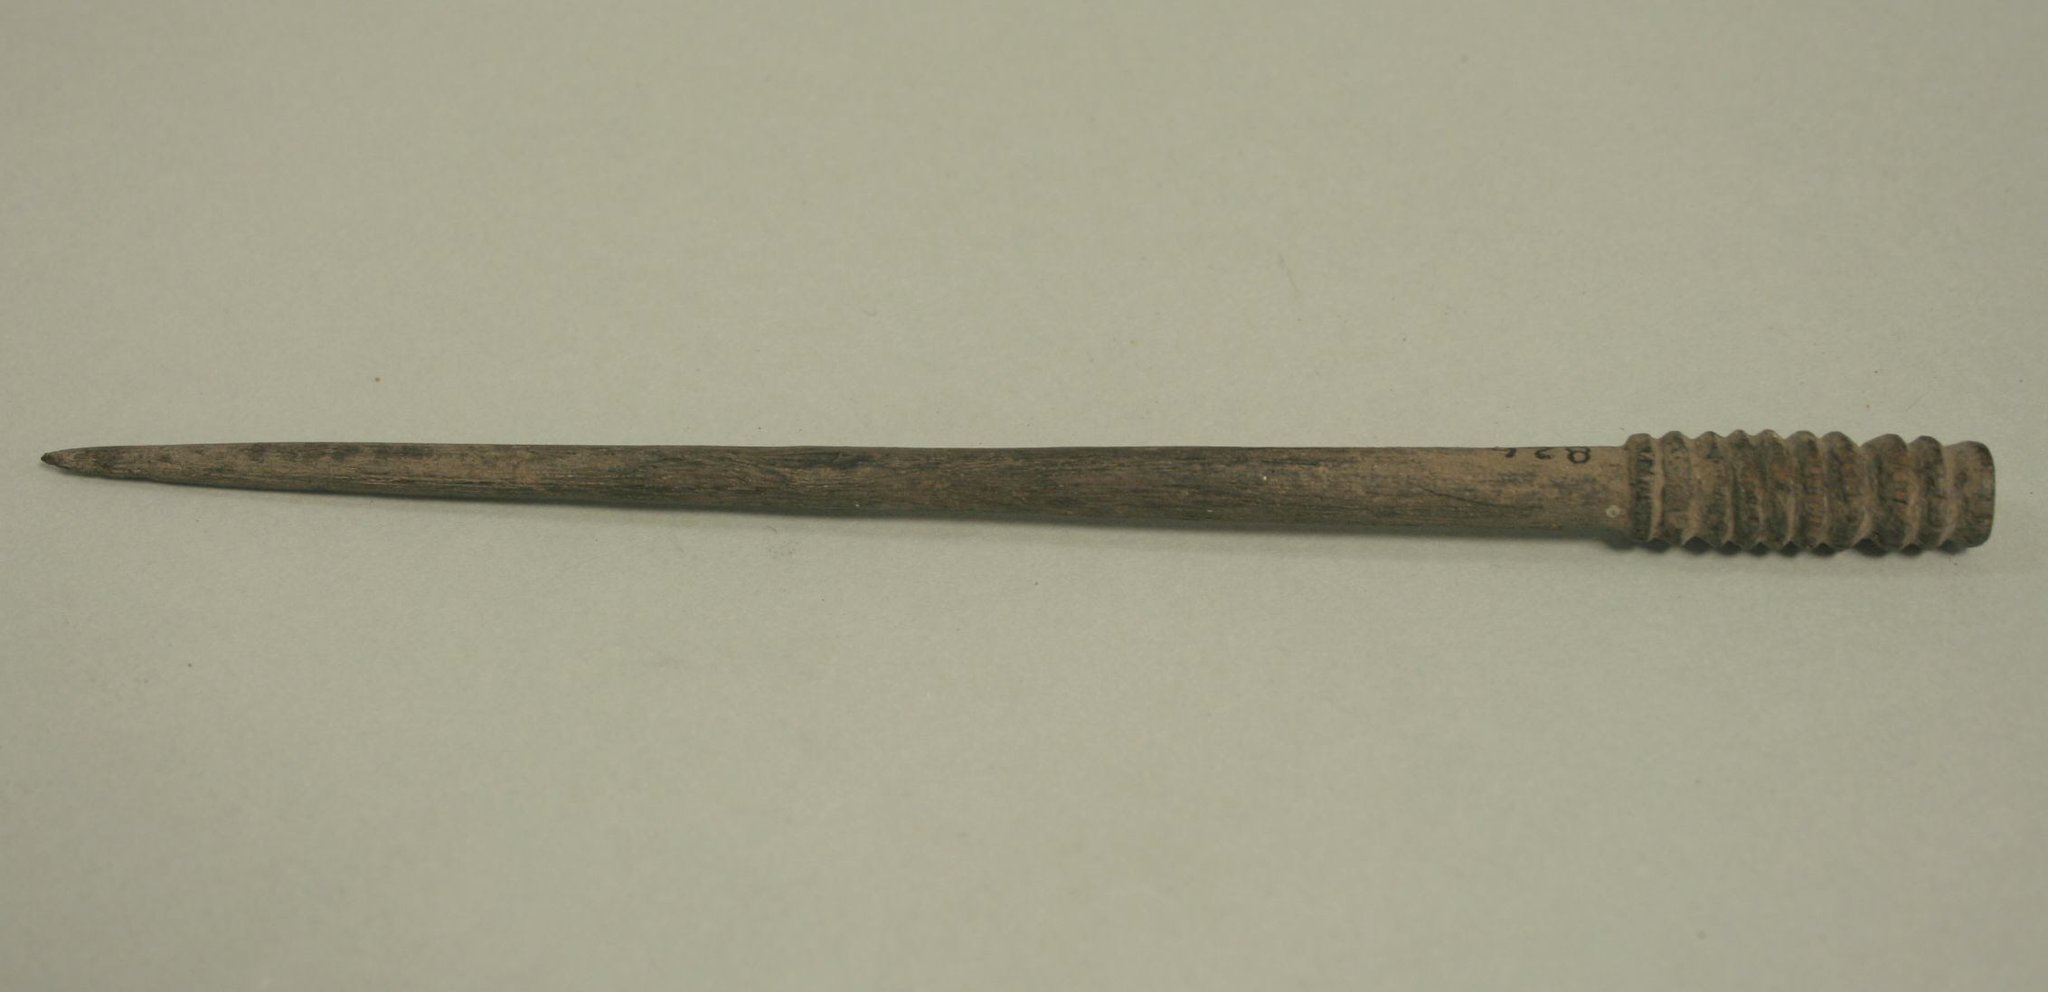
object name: weaving tool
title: Wooden Weaving Tool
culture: peruvian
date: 1501-1600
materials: wood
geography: peru